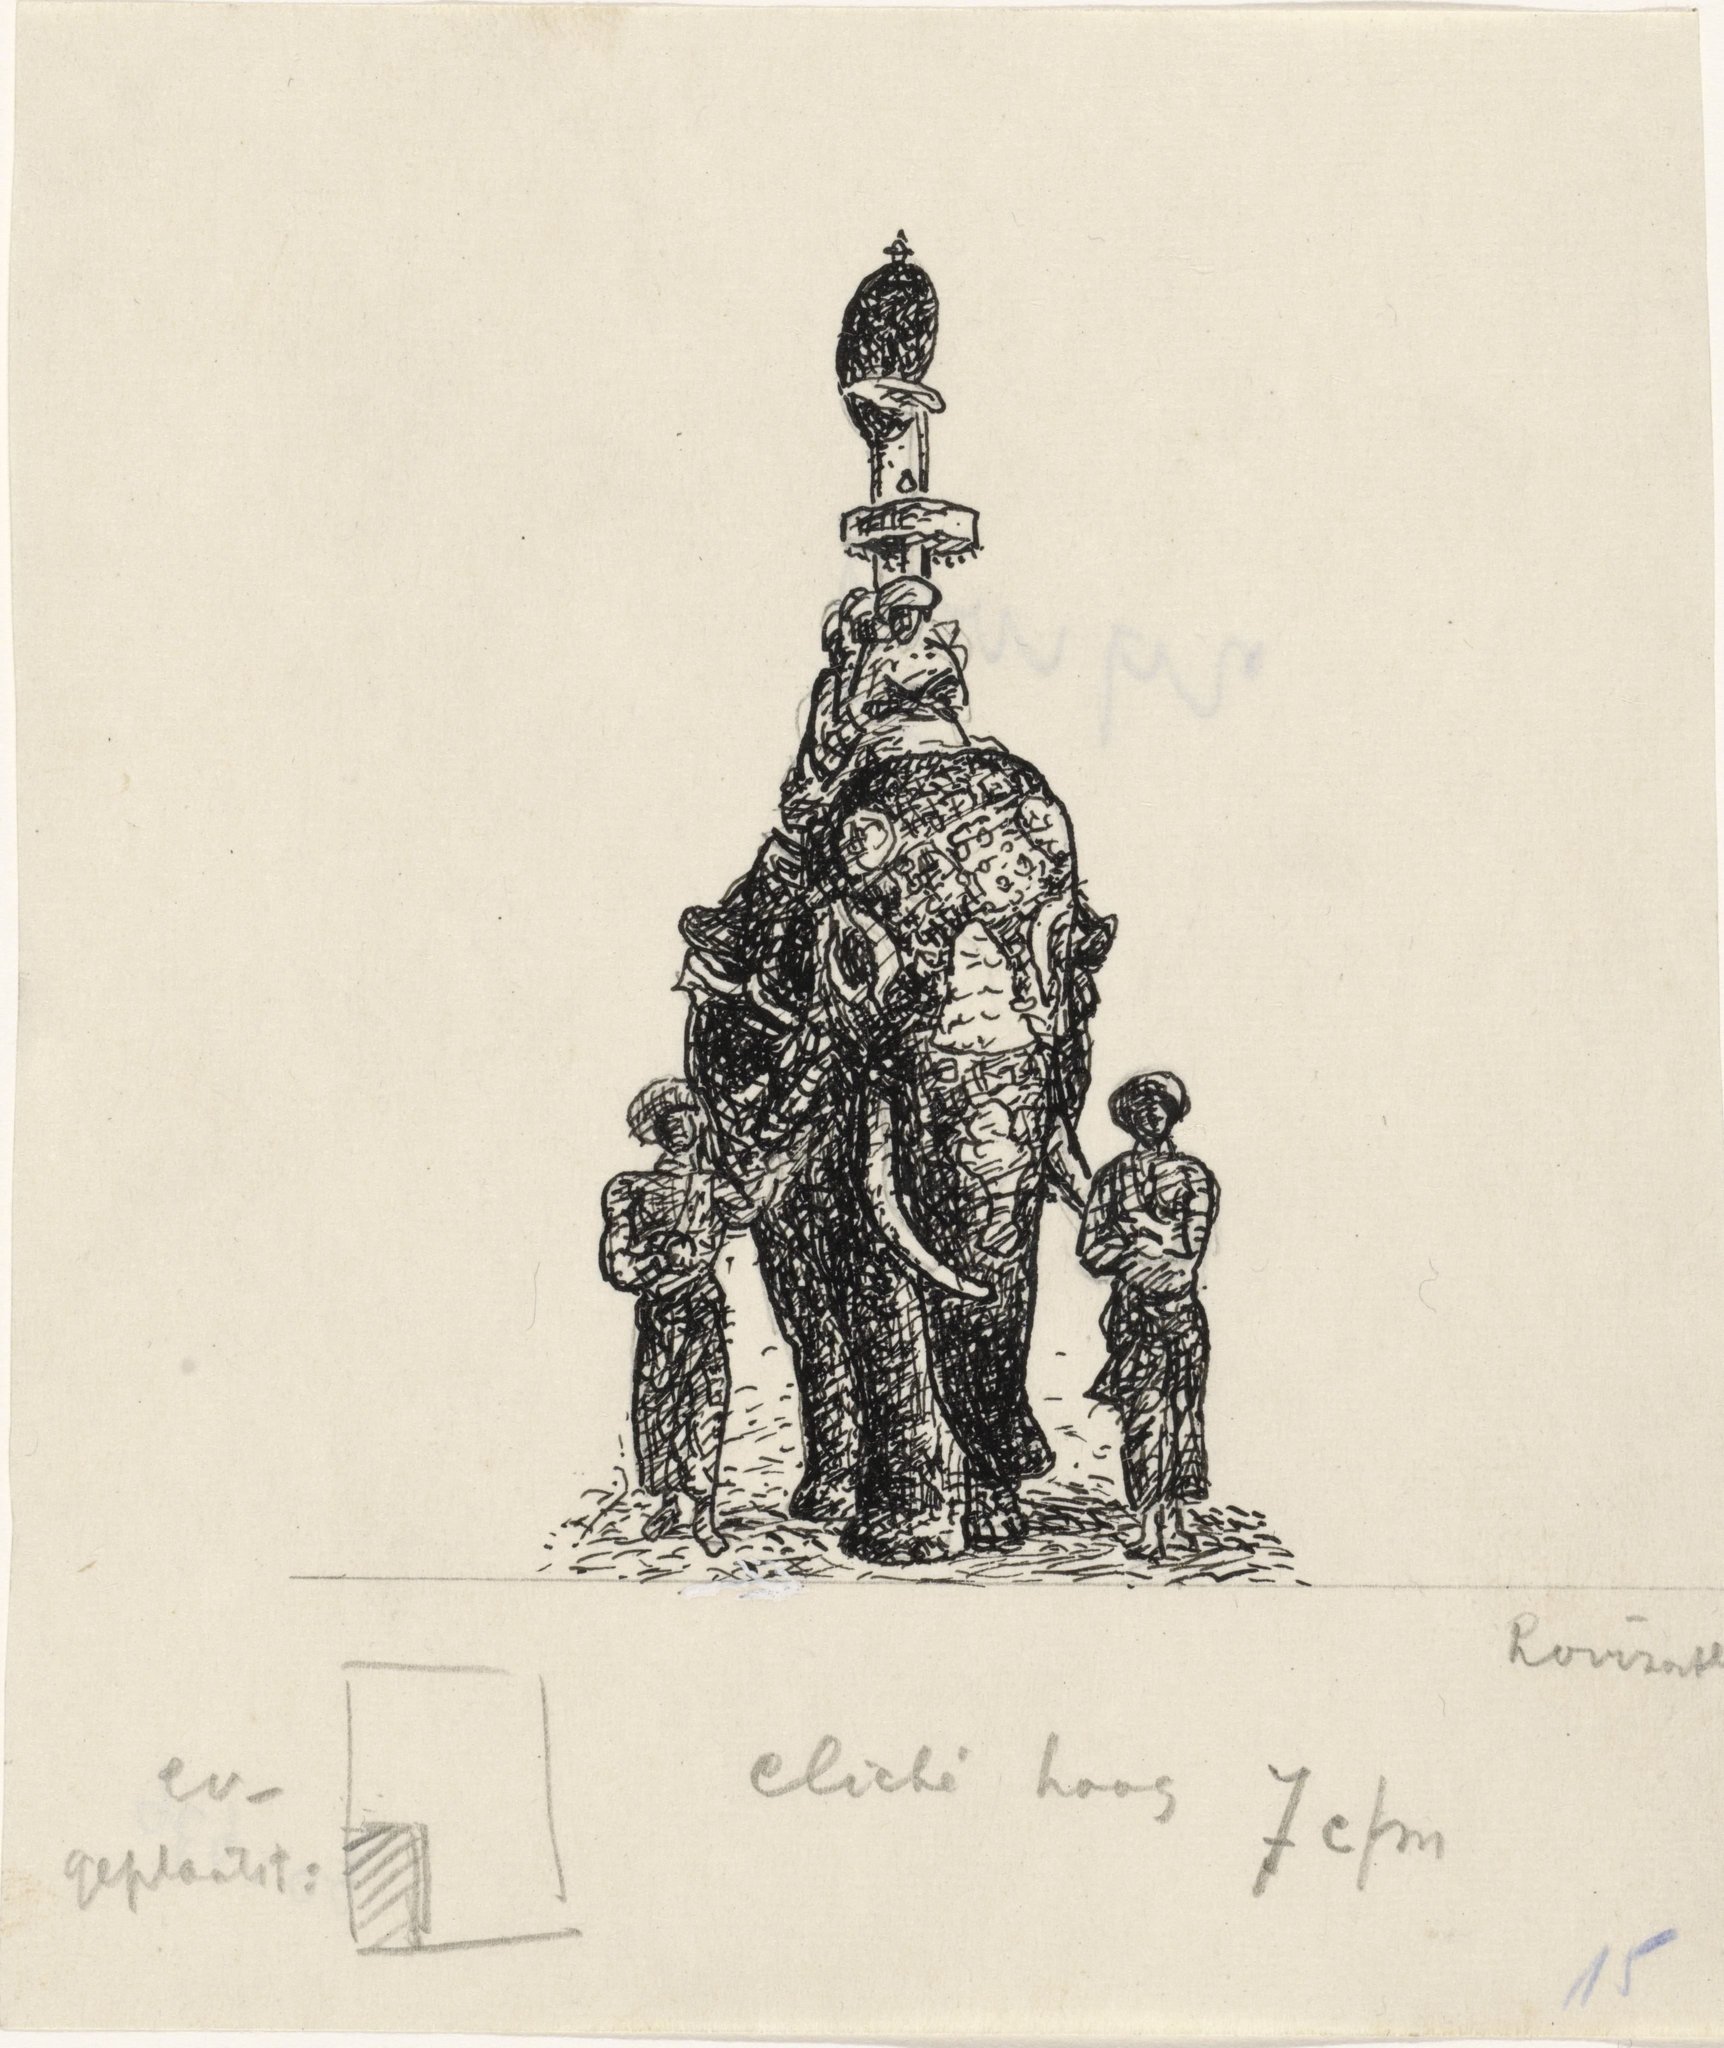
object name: boekillustratie ontwerp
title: Indiase olifant bereden door figuren met twee begeleiders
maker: leo gestel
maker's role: draughtsman, print maker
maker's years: 1881-1941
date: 1934-1936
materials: ink, paper, pencil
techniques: pen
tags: (cohen, van anarchist tot monarchist) specific works of literature (with author, title), trunked animals: elephant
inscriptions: clichéaanwijzing, recto, handgeschreven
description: Ontwerp mogelijk voor een boekillustratie voor: Cohen, Alexander. Van anarchist tot monarchist. Amsterdam: De Steenuil, 1936.